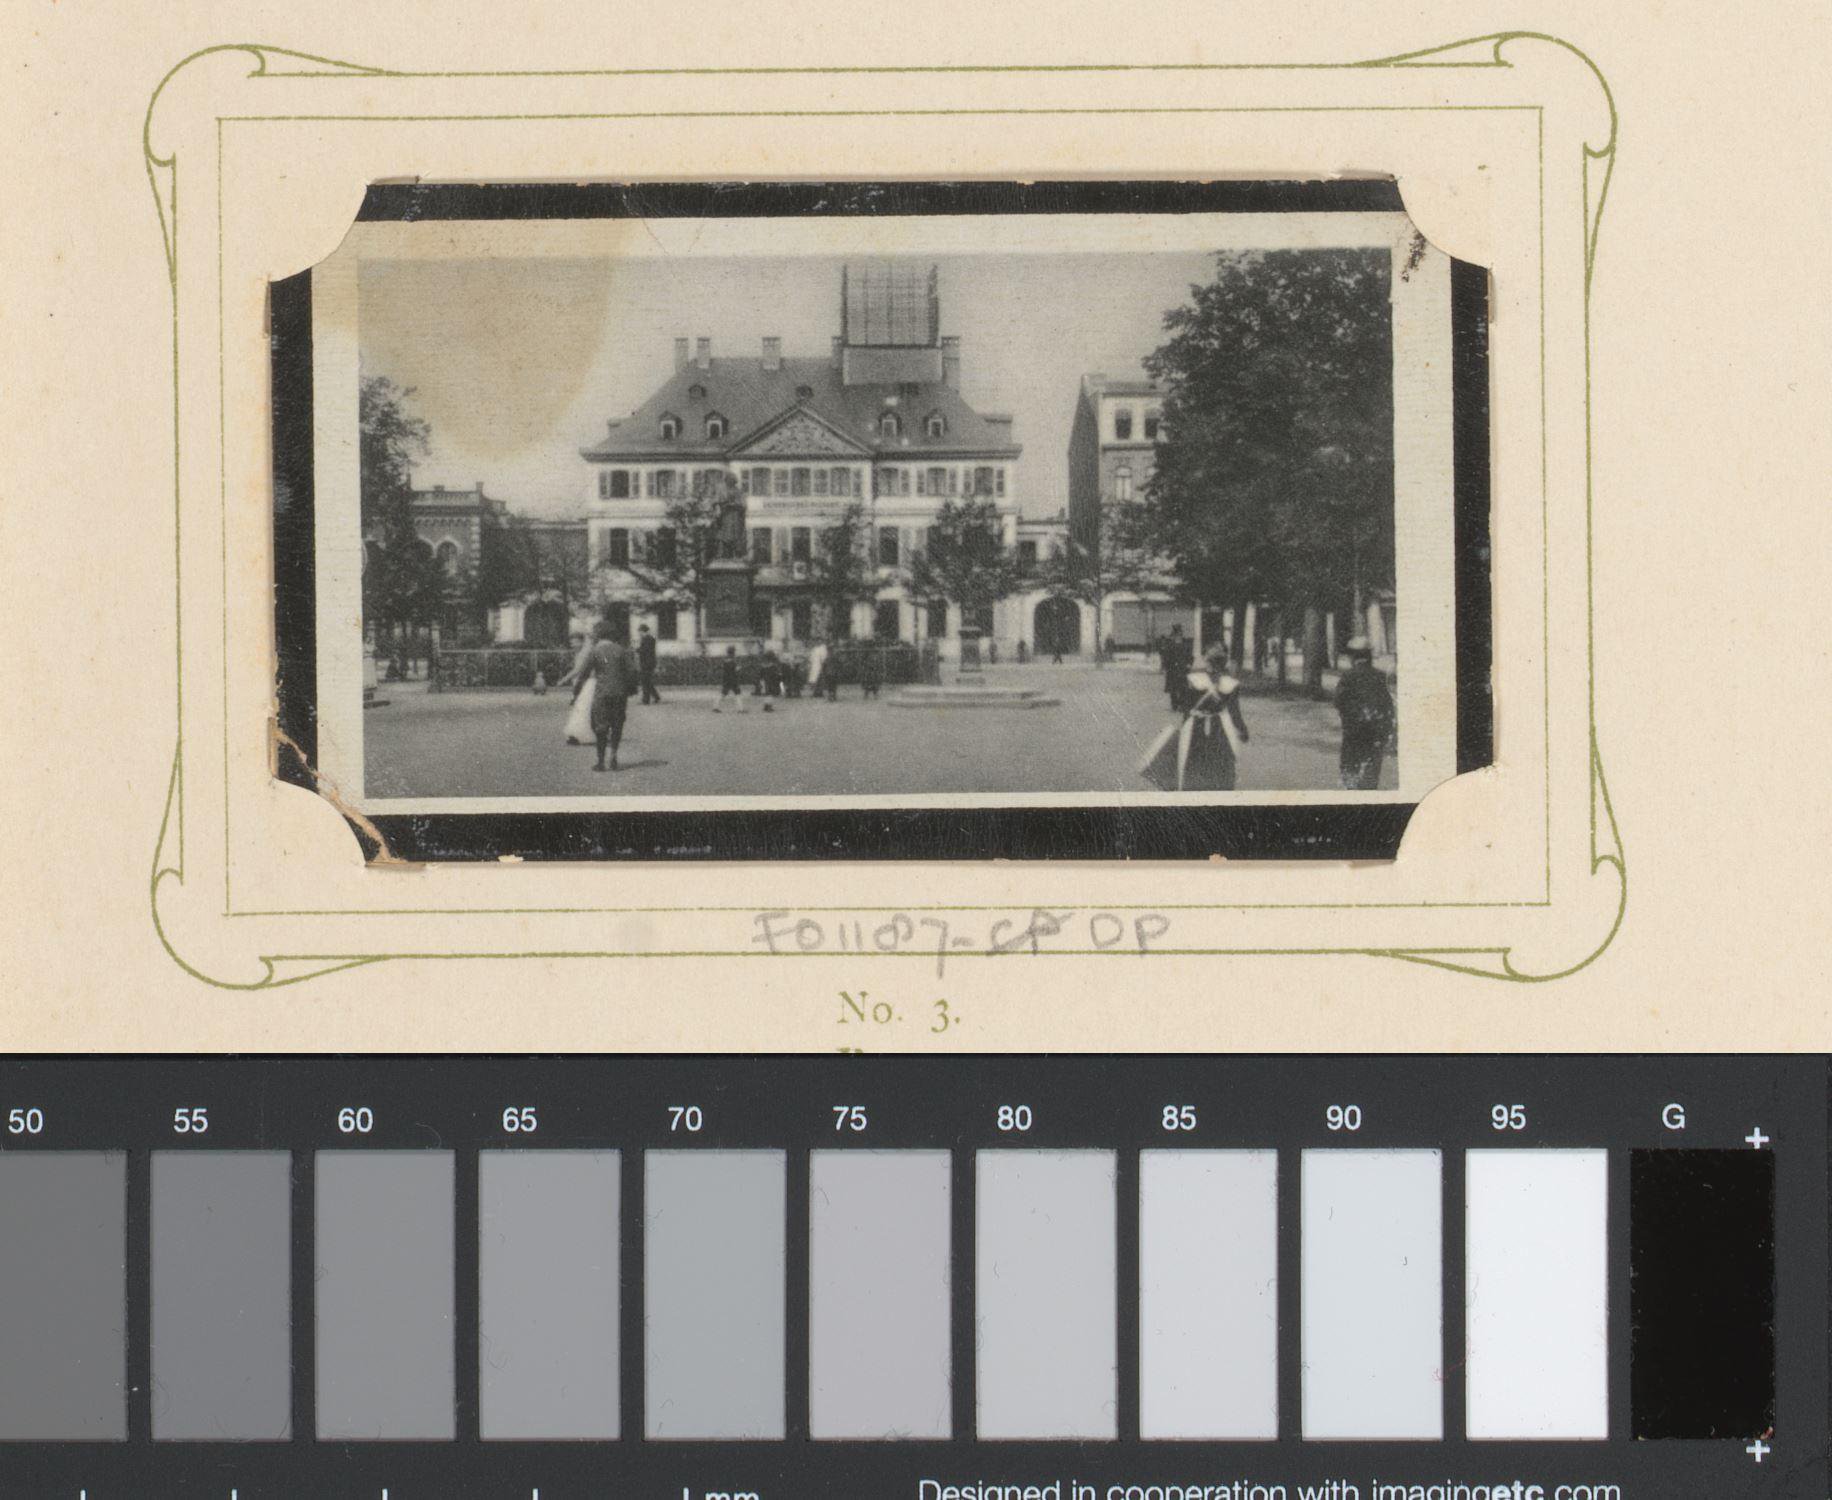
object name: album leaf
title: Gezicht op Bonn, Duitsland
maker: Anonymous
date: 1905-1906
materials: paper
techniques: photograph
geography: bonn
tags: prospect of city, town panorama, silhouette of city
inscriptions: inscription: ‘No. 3./ Bonn.’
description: Deze prent maakt deel uit van een album.